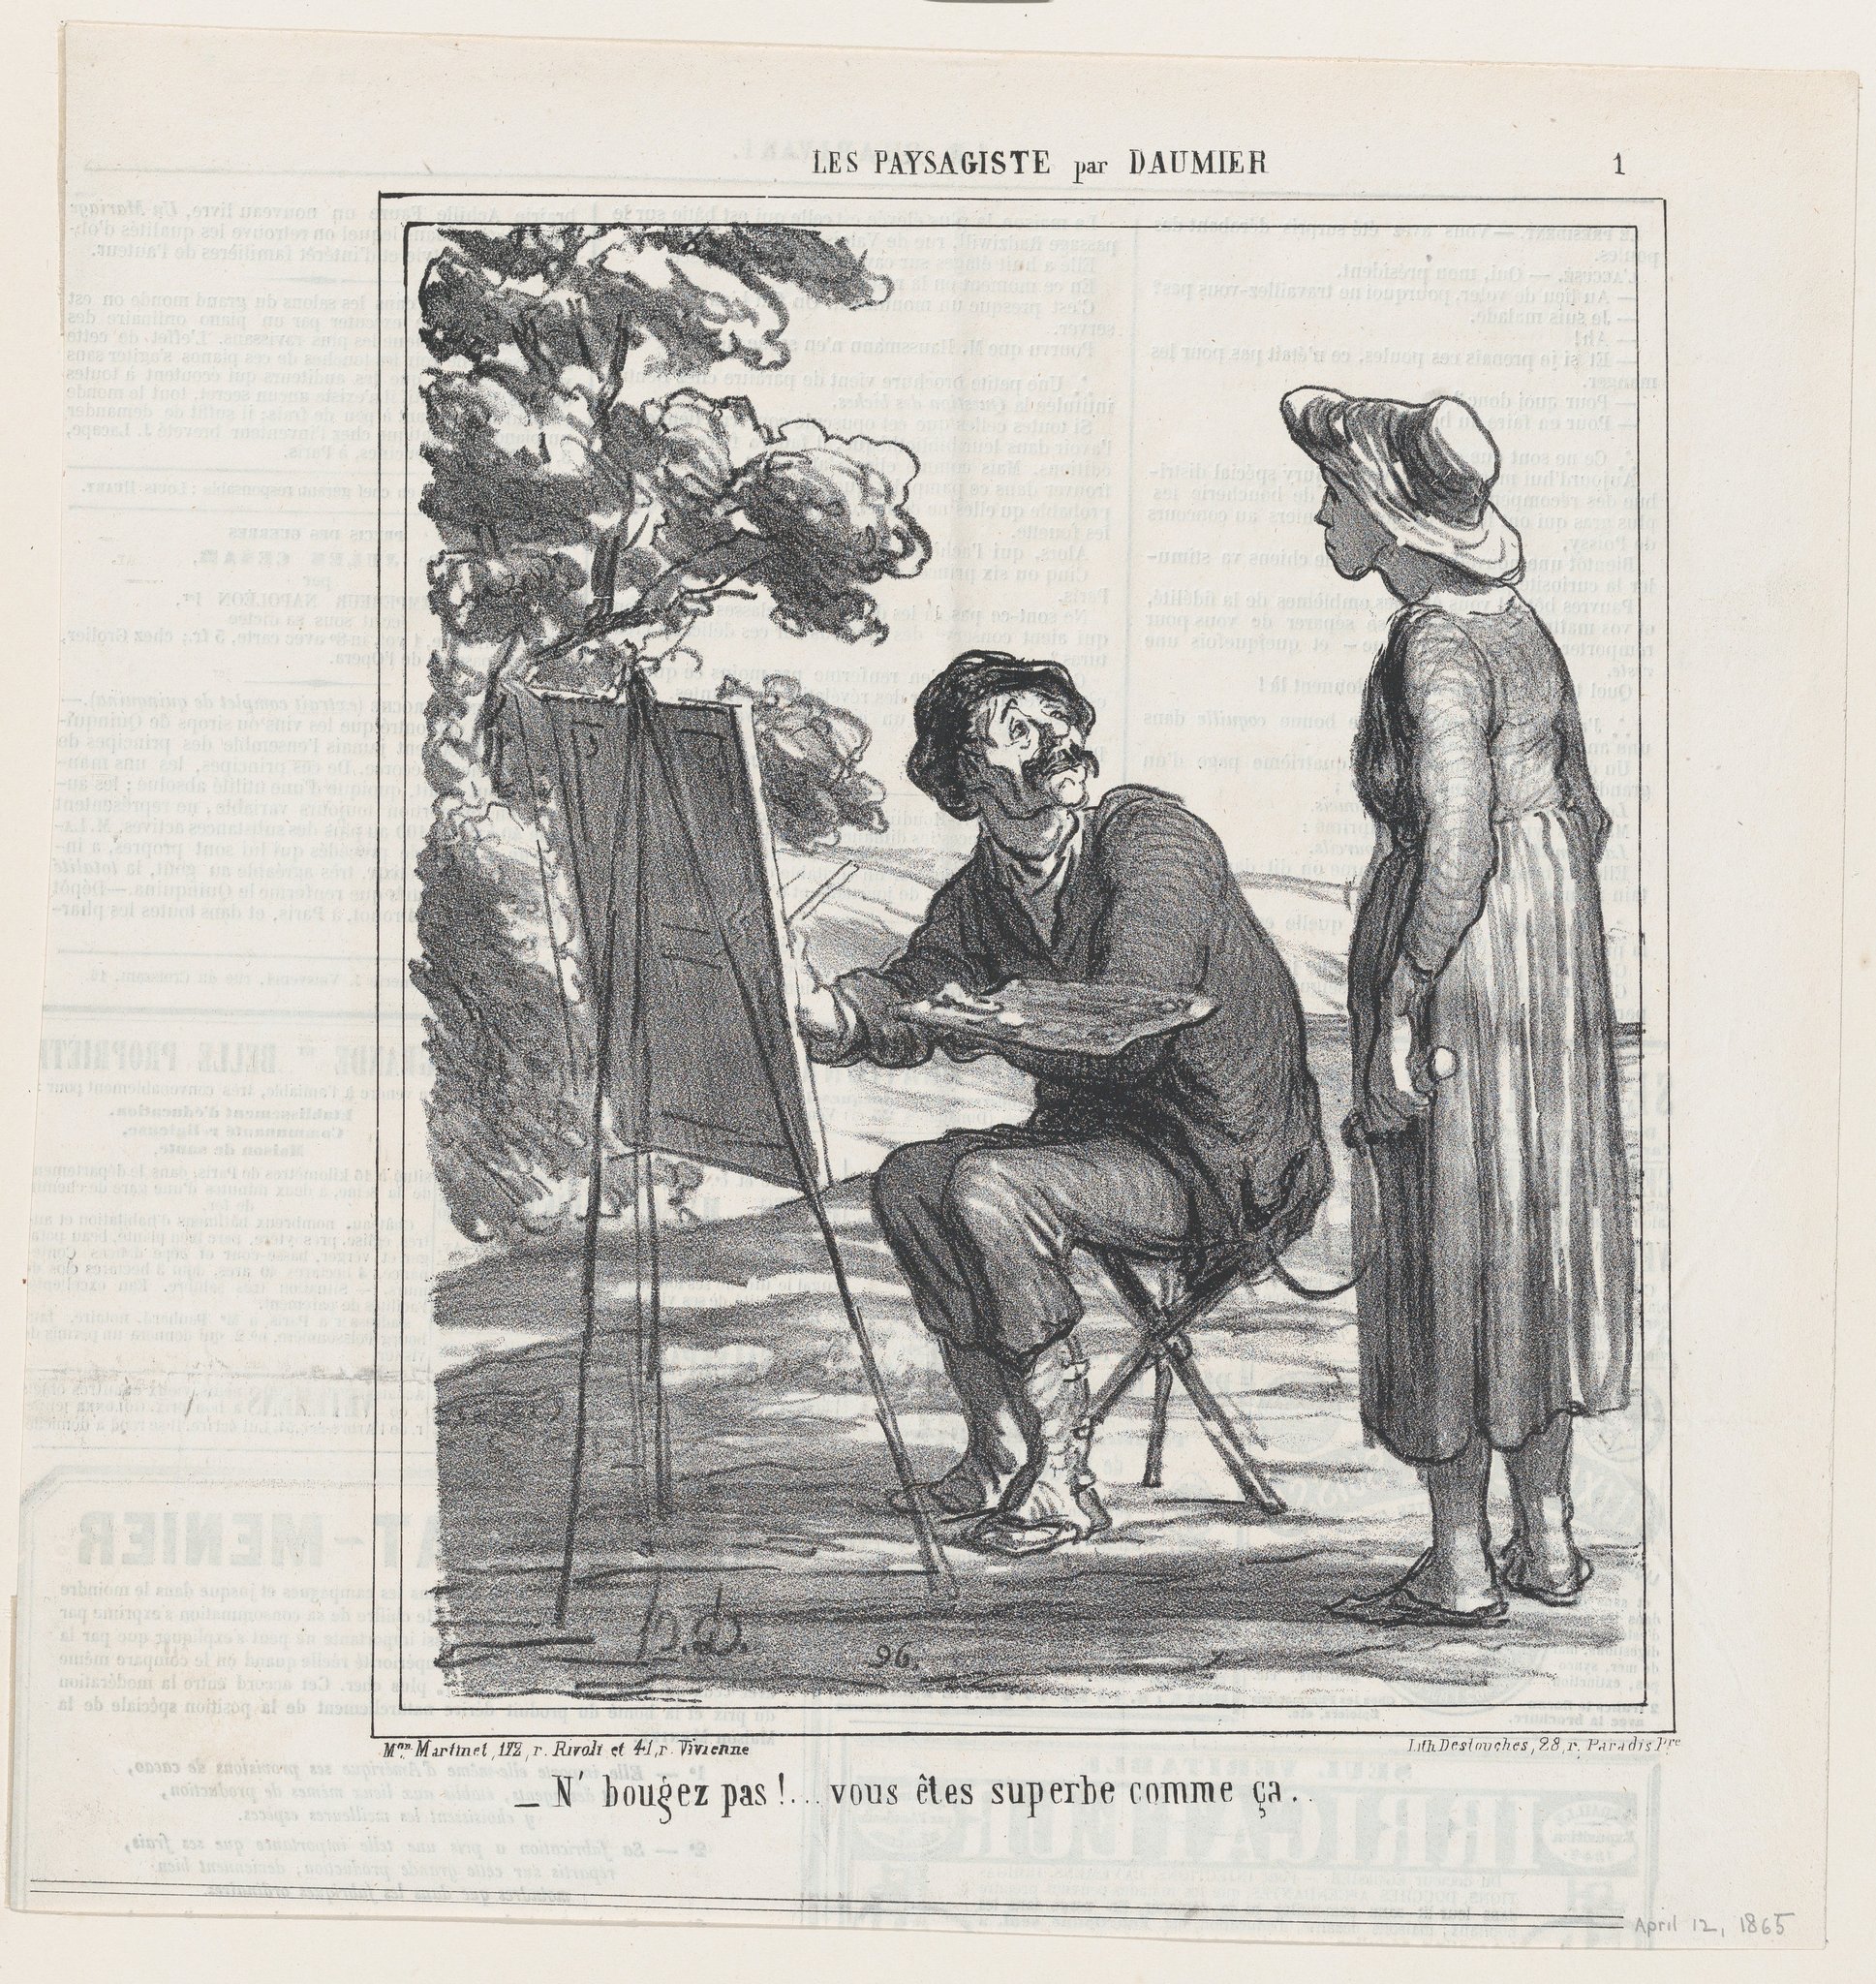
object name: print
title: Don't move... you are superb just like that..., from 'The landscape painters,' published in Le Charivari, April 12, 1865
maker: honoré daumier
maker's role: artist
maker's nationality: french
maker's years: 1808-1879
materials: paper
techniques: lithograph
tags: painting,men,women